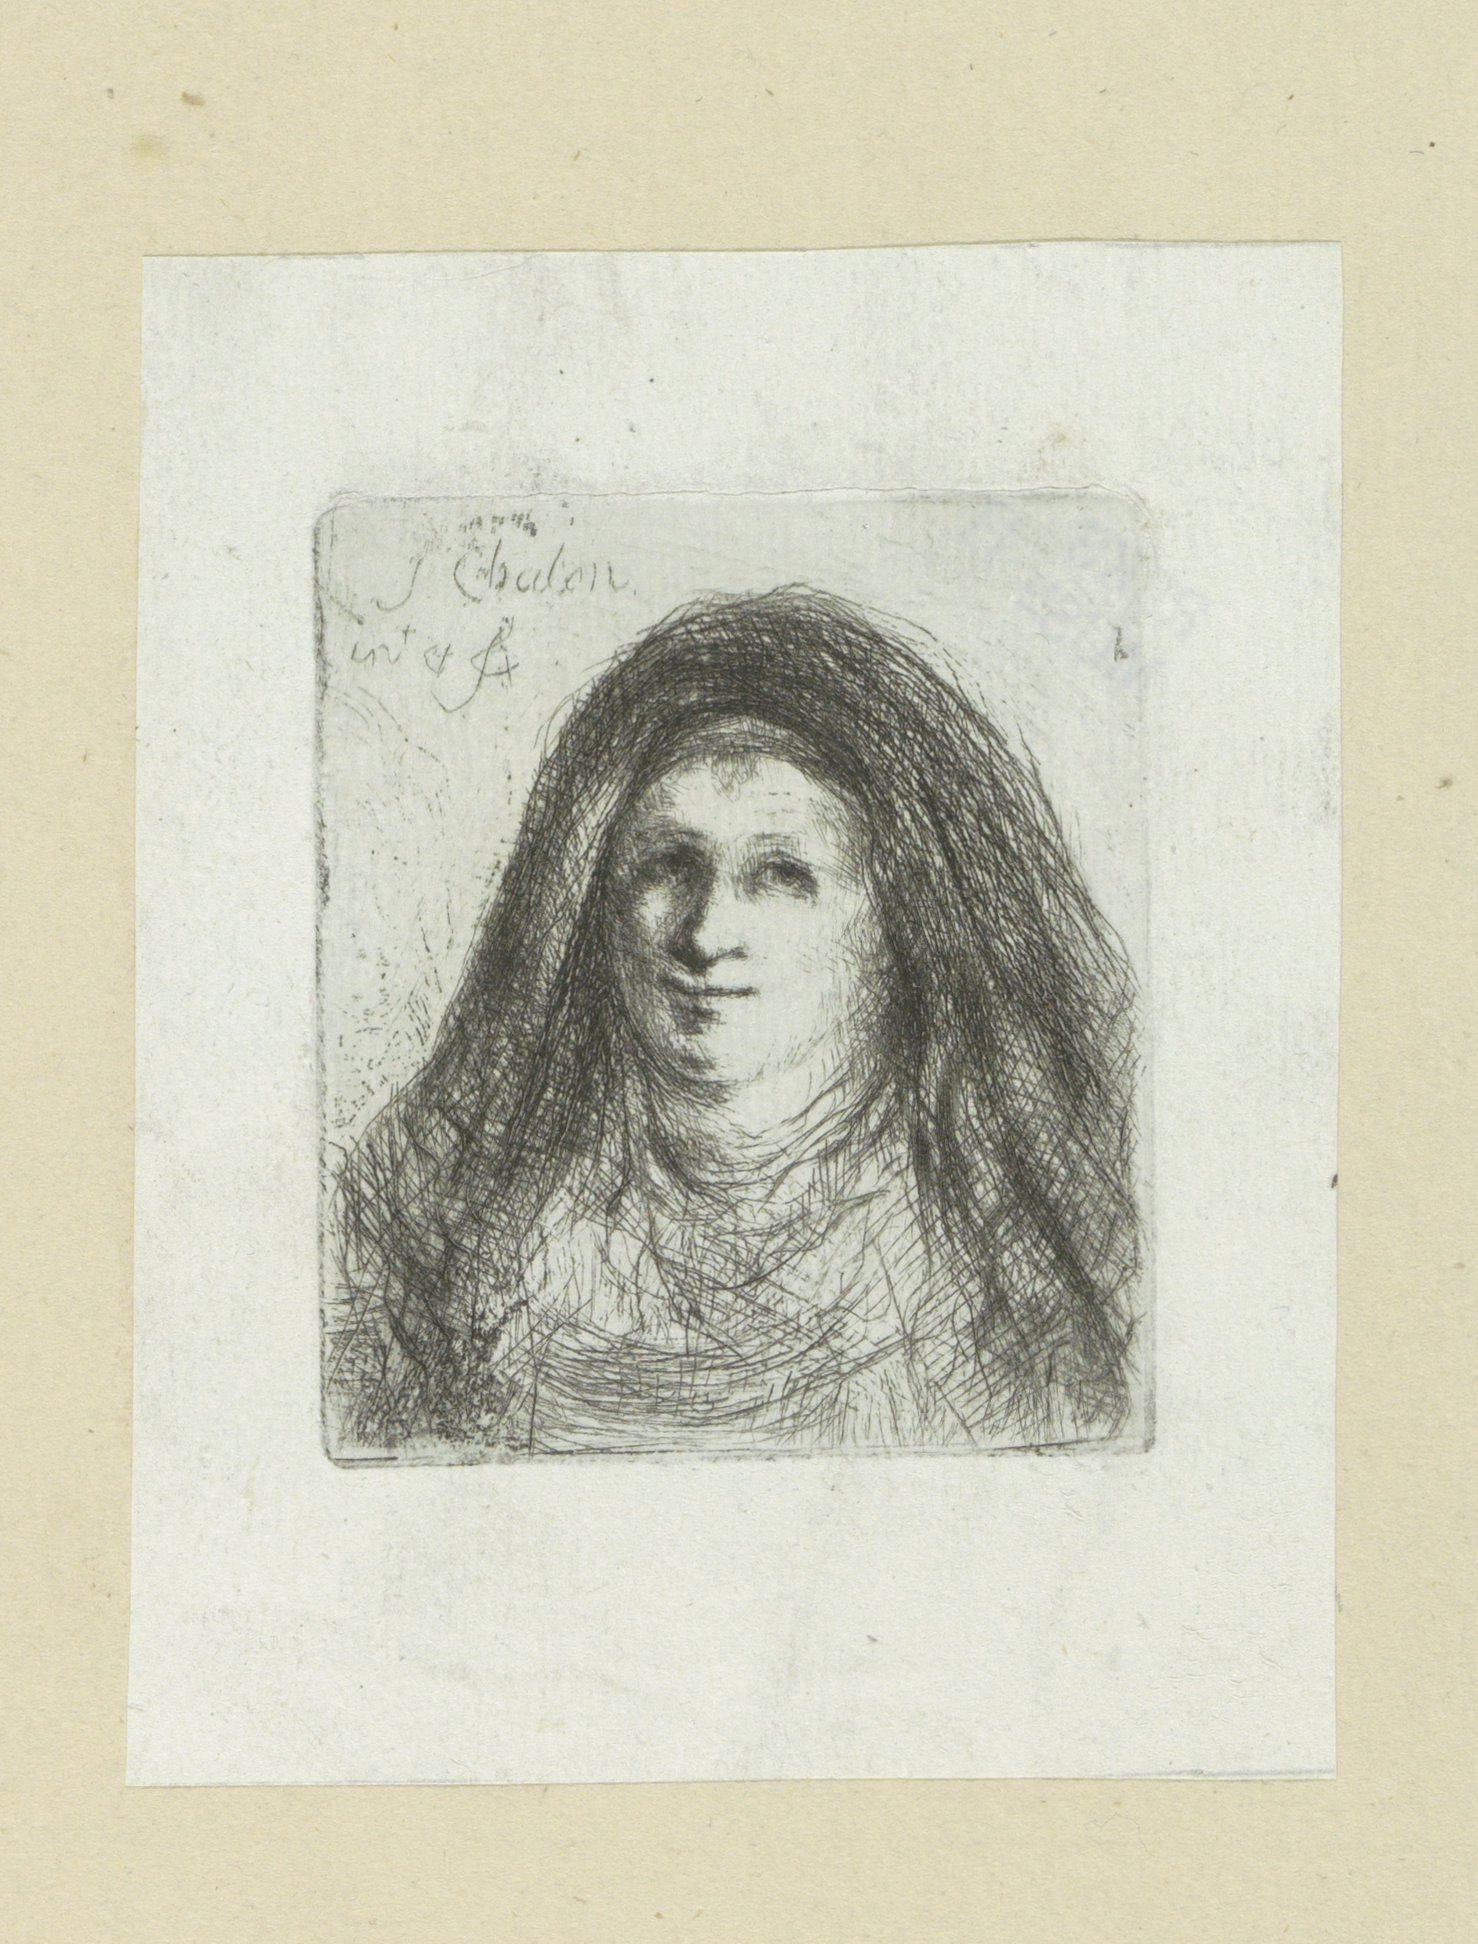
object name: print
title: Volwassen vrouw met hoofddoek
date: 1802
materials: paper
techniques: drypoint, etching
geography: london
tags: veil, morphology of human expression (+ adult female (human being))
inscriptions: collector's mark: ‘RIJKS / MUSM’, collector's mark: ‘B’